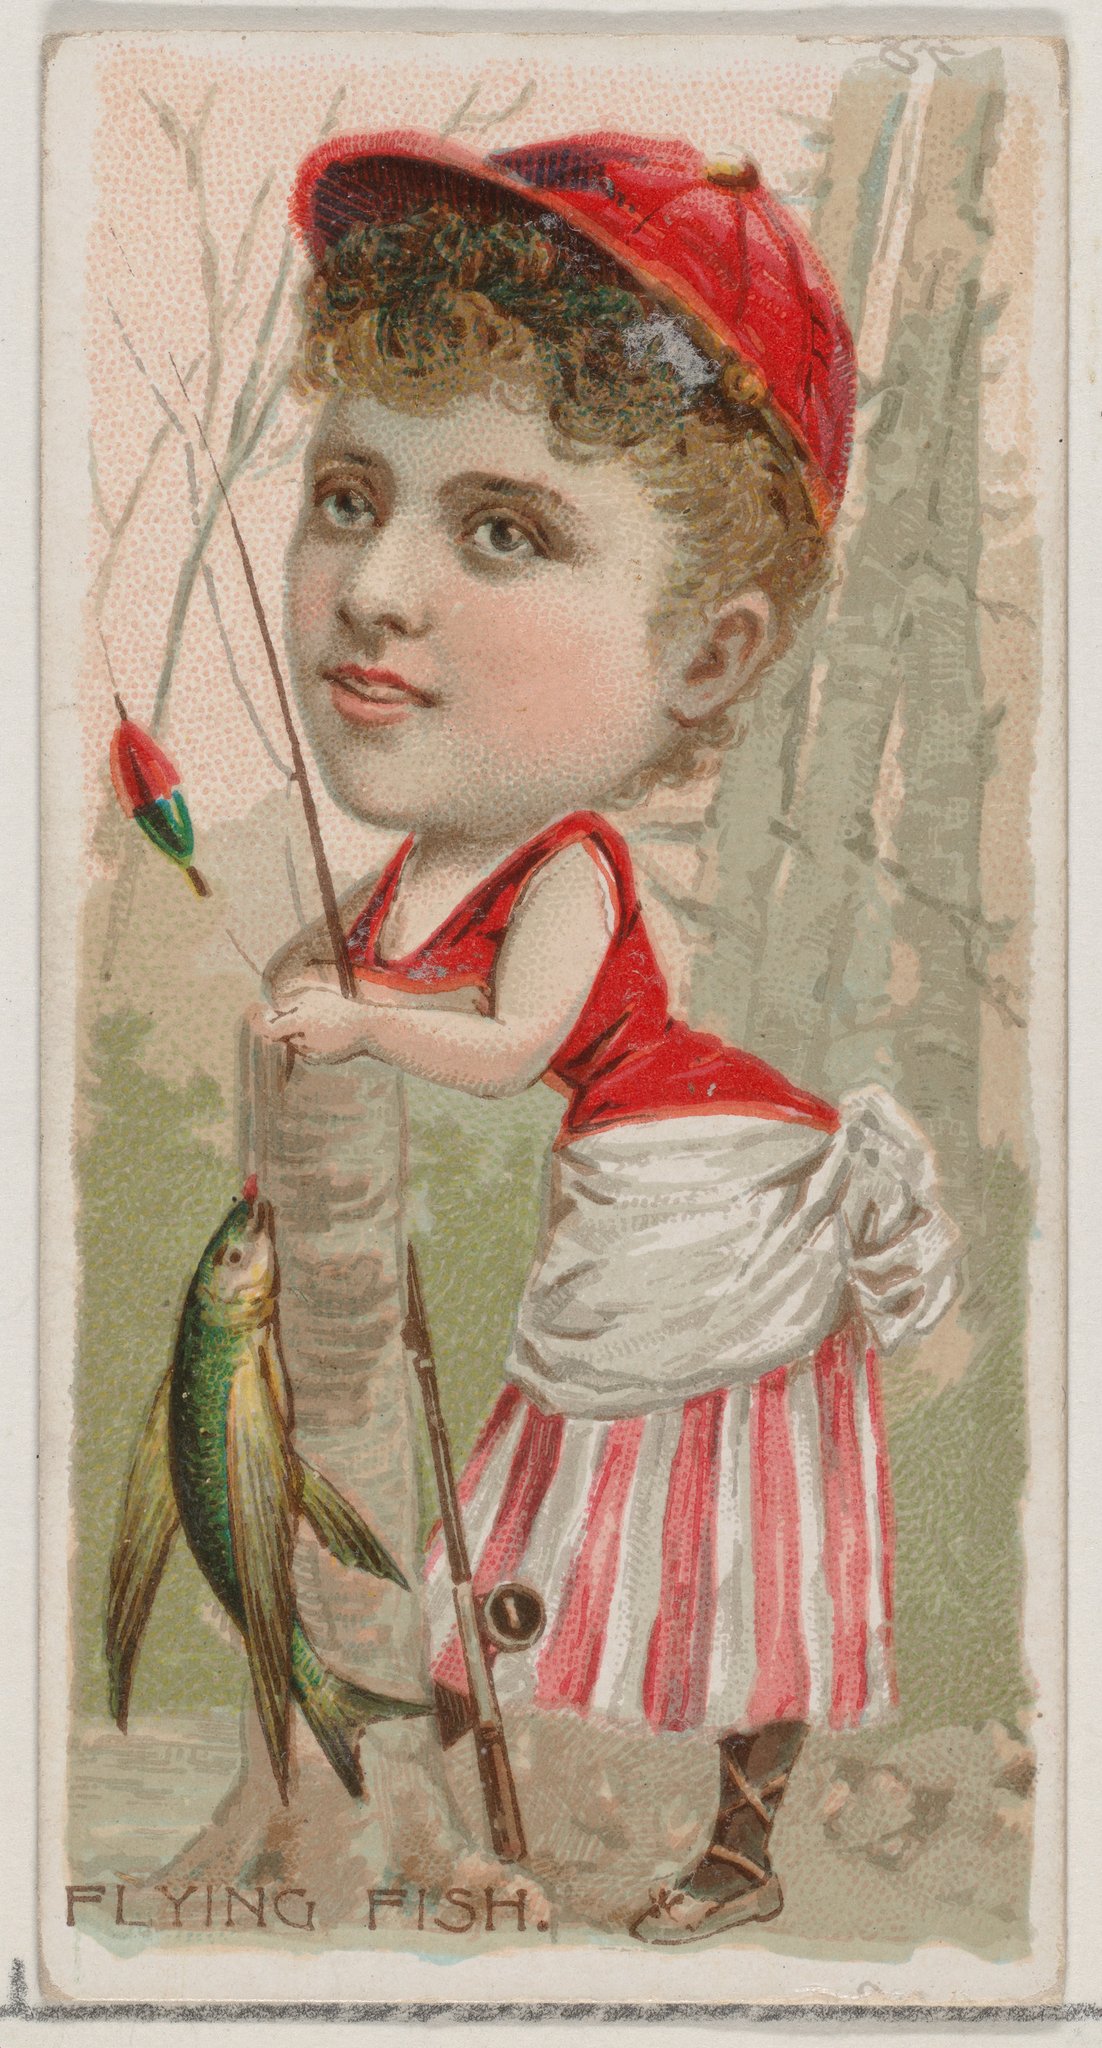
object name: print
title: Flying Fish, from the series Fishers and Fish (N74) for Duke brand cigarettes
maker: knapp & company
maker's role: lithographer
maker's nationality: american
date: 1888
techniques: color lithograph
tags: women,fishing,fish